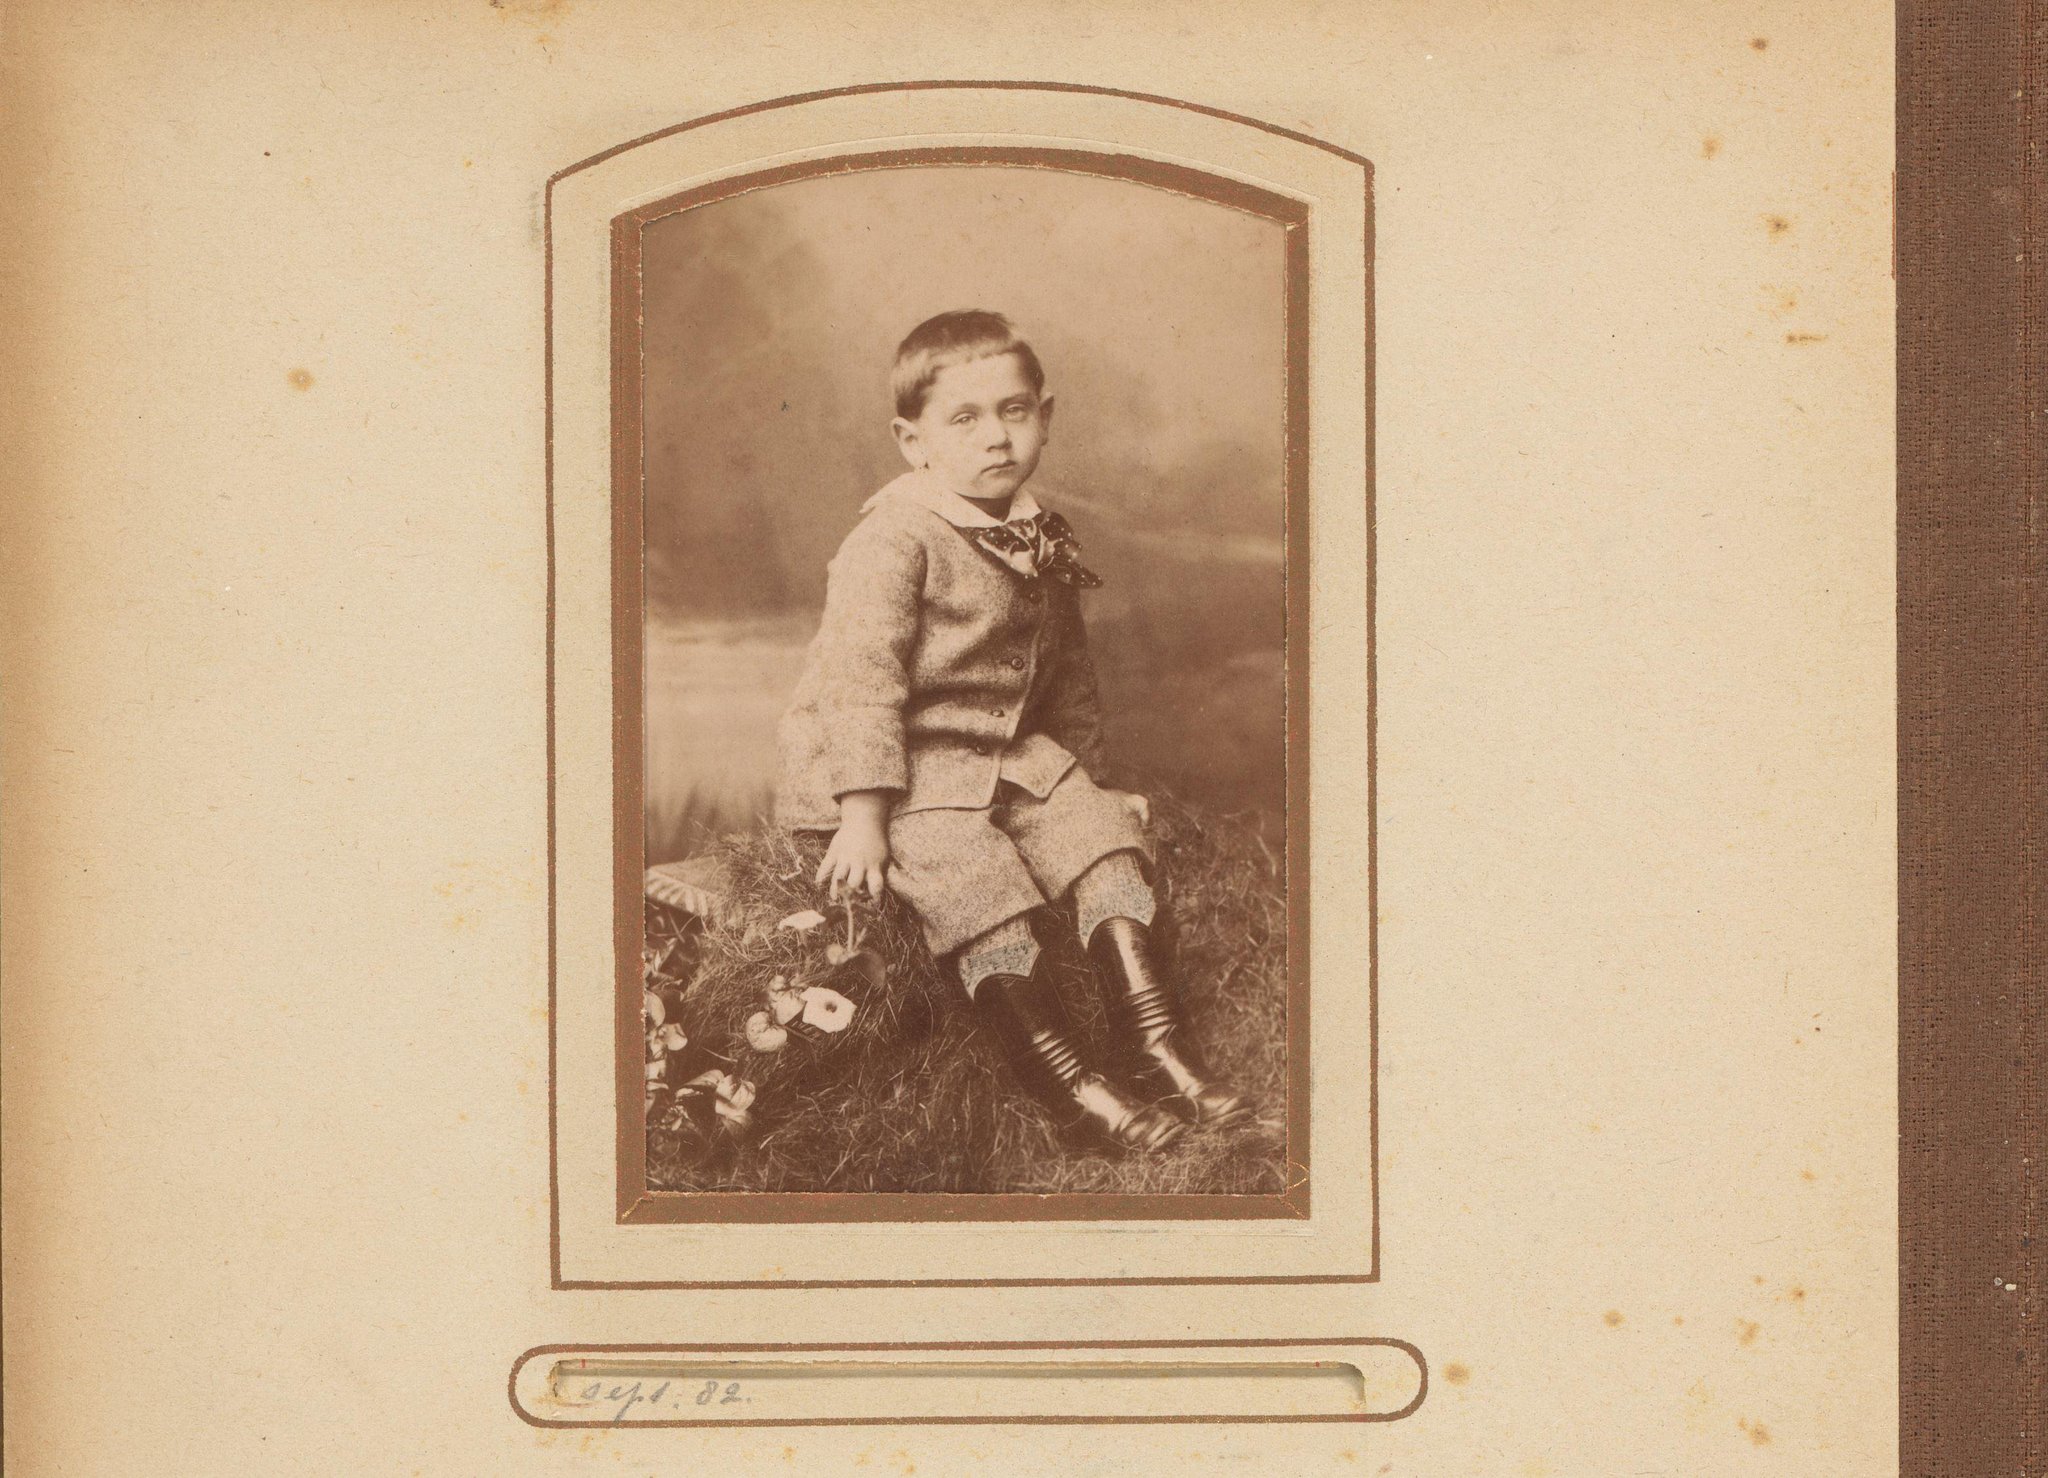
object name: photograph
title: Portret van een jongen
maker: Anonymous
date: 1882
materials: cardboard, photographic support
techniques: albumen print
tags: boy (child between toddler and youth), historical persons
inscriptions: annotation: ‘sept 82’